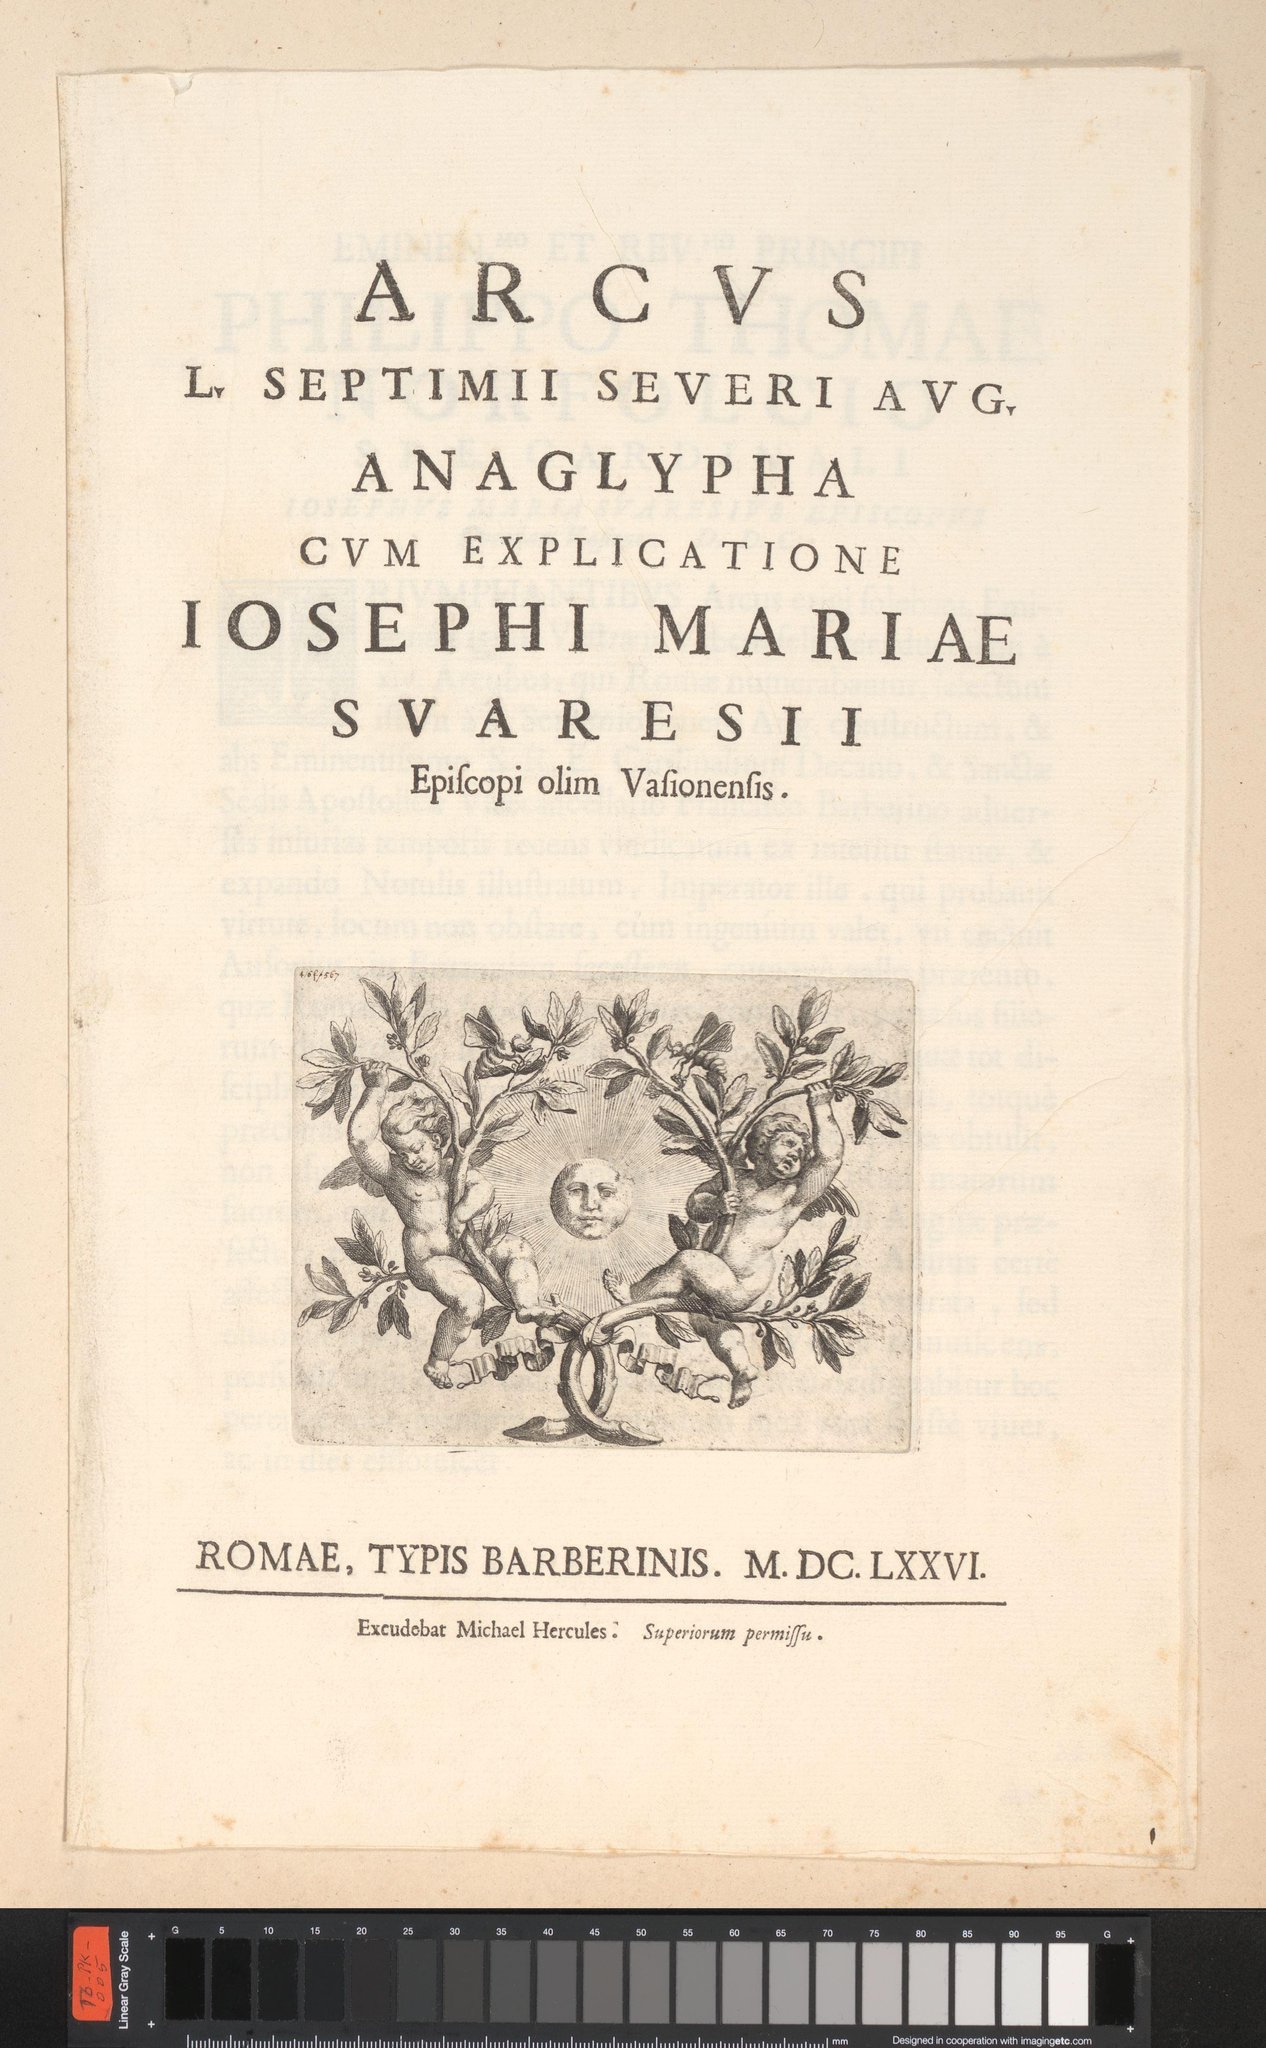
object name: album leaf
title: Vignet met bijen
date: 1676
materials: paper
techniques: etching, intaglio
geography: rome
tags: sun represented as face, wheel, etc., insects: bee, foliage, tendrils, branches ~ ornament, cupids: 'amores', 'amoretti', 'putti'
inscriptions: number: ‘1’, inscription: ‘4/6 f / 5 6 7’, number: ‘34’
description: Vignet afkomstig uit de publicatie: Suares, Joseph Marie. Arcus L. Septimii Severi Aug. Rome: Michael Hercules, 1676. Het blad met het vignette is samen met zeven andere bladen uit dezelfde publicatie geplakt op albumbladen genummerd 34-36.